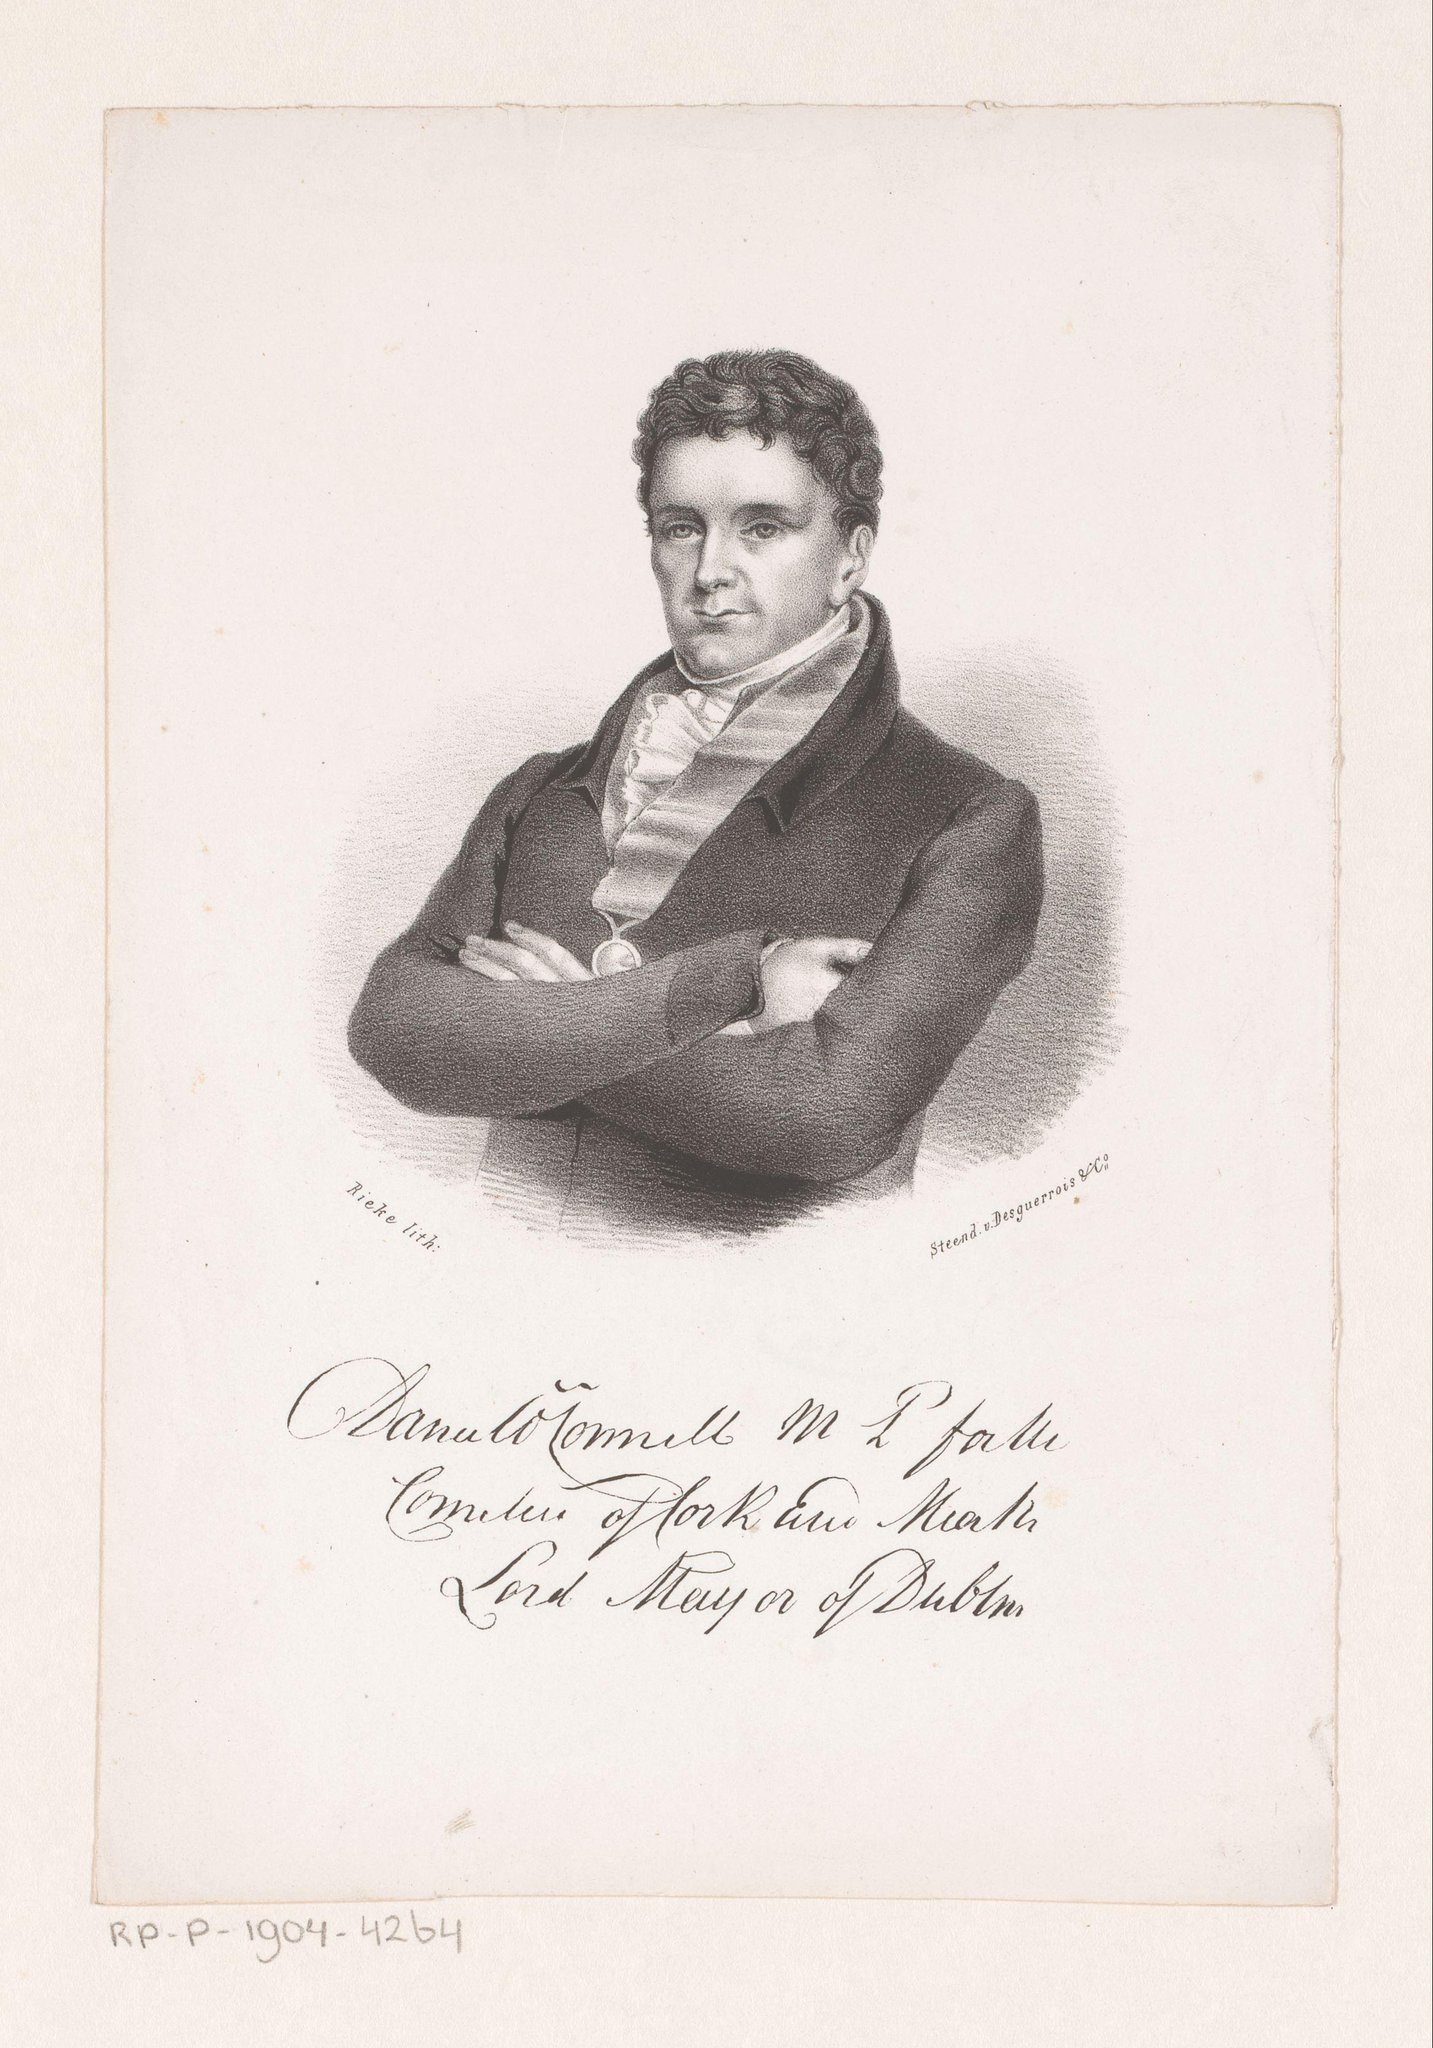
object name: print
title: Portret van Daniel O'Connell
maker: johan george lodewijk rieke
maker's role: draughtsman, print maker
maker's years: 1817-1898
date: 1827-1847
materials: paper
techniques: lithograph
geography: amsterdam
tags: historical persons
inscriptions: collector's mark: Lugt 2228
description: Onder het portret de signatuur van de geportretteerde.